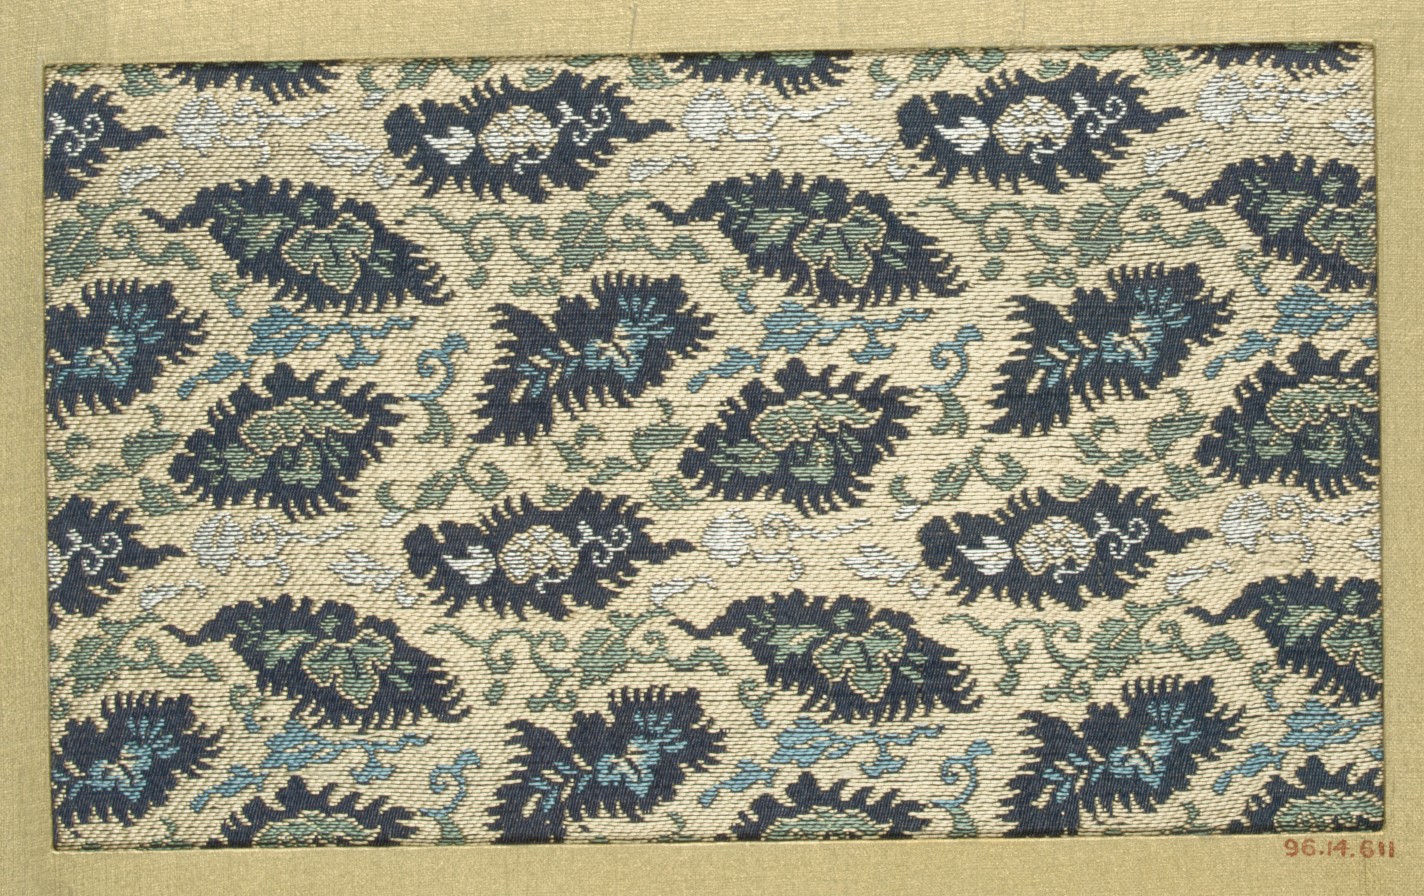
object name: piece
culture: japanese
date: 1701-1900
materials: silk